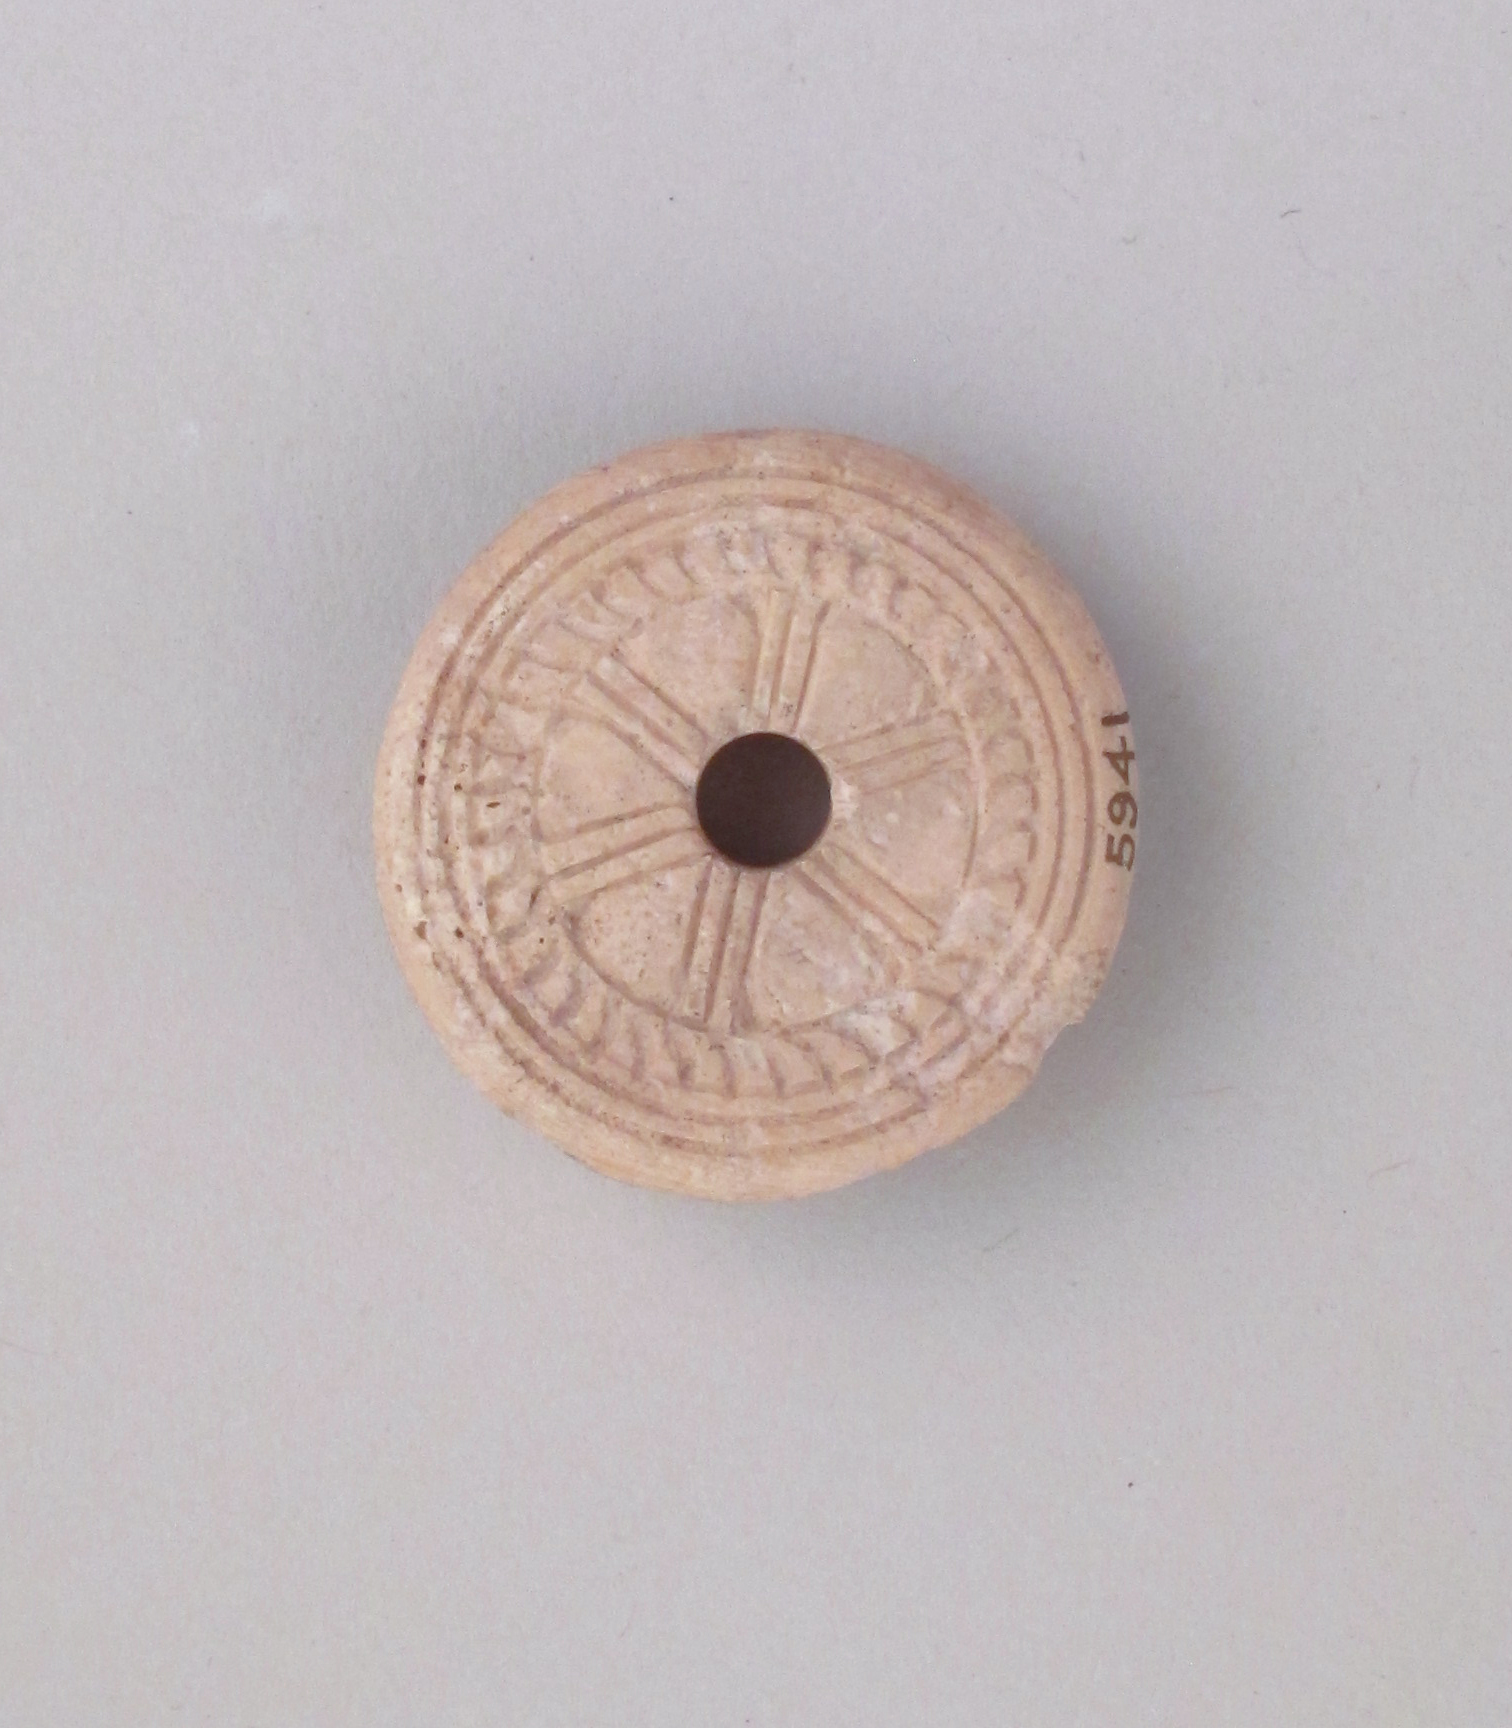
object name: spindle whorl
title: Ivory spindle whorl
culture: cypriot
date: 1300-1101 BCE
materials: ivory